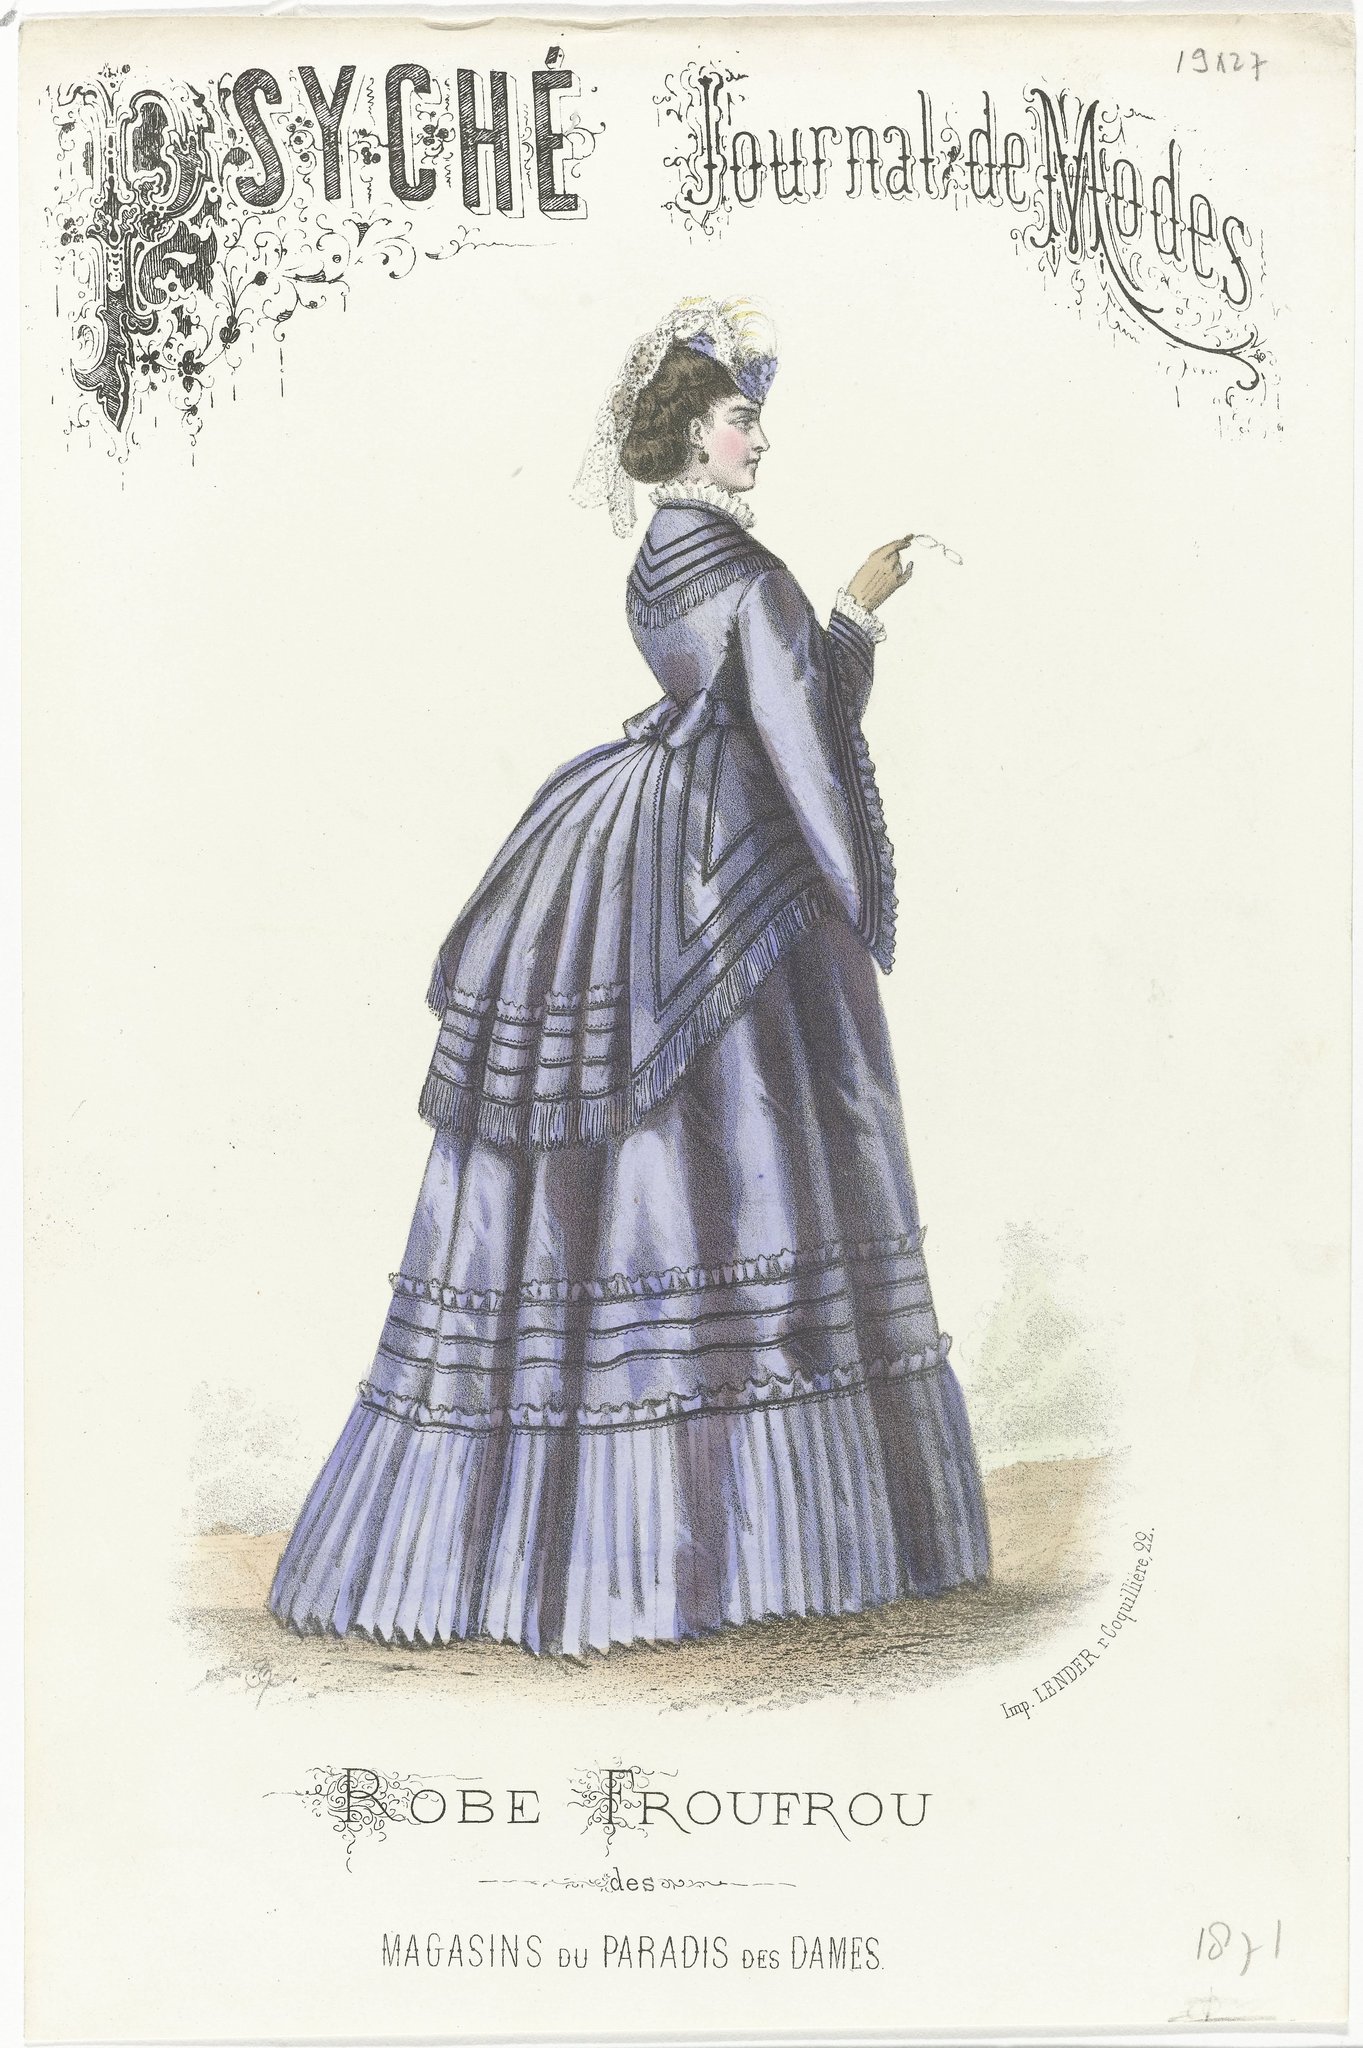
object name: fashion print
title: Psyché Journal de Modes, 1871 : Robe Froufrou des (...)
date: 1871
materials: paper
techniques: hand coloring, lithograph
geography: paris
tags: ear-rings (+ women's clothes), eyeglasses, spectacles - aa - female human figure, head-gear (+ women's clothes), fashion plates, gloves, mittens, etc. (+ women's clothes), dress, gown (+ women's clothes)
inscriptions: title: ‘Psyché Journal de Modes’, caption: ‘Robe Froufrou des Magasins du Paradis des Dames’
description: Vrouw, op de rug gezien, in een japon met queue in de stijl 'froufrou'. Prent uit het modetijdschrift Psyché (1834-1878).